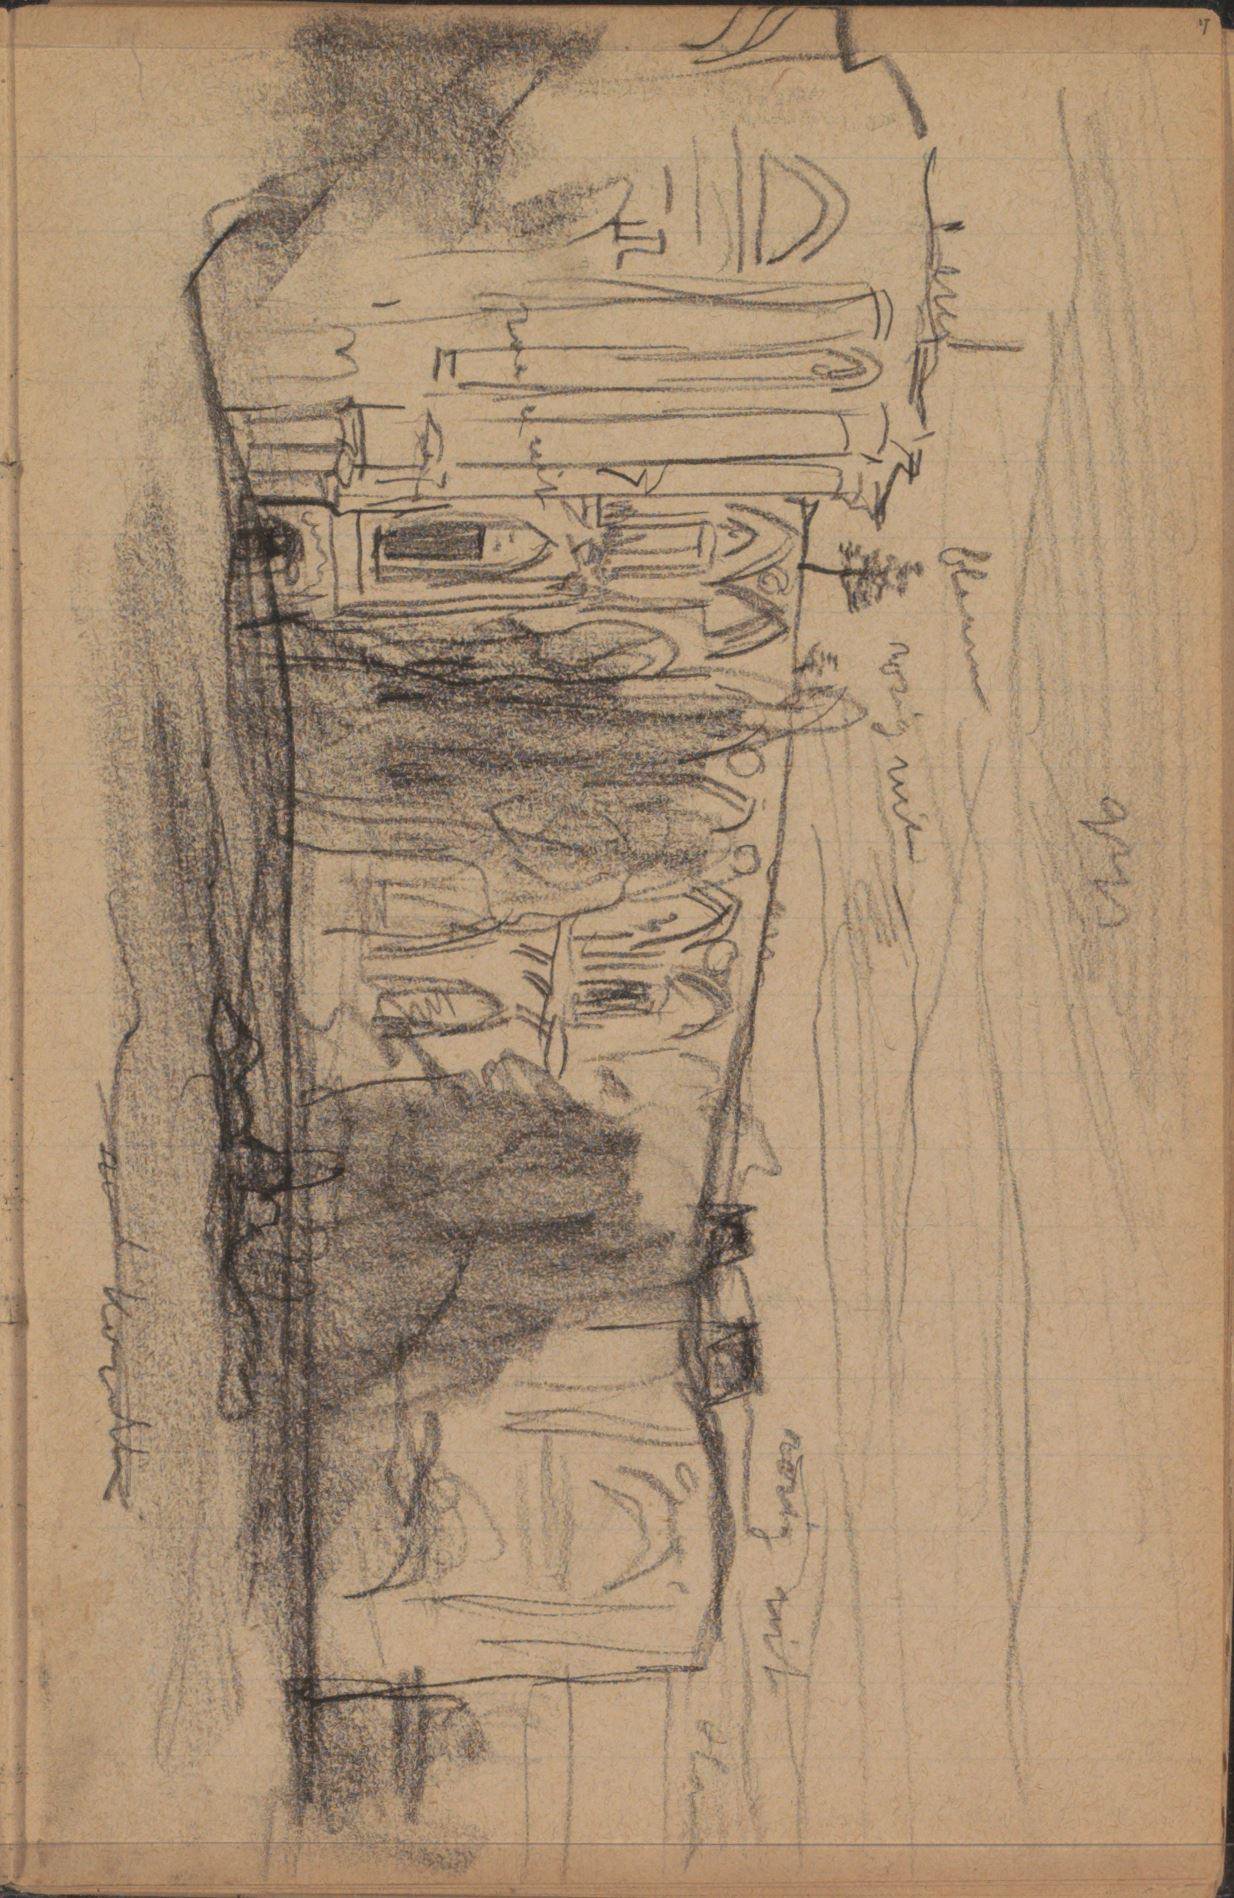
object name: sketchbook leaf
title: Architectuurstudie, mogelijk van een paleis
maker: marius bauer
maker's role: draughtsman, print maker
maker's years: 1867-1932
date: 1896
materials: chalk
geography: russia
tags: architecture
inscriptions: kleurnotitie, handgeschreven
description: Pagina 17 uit een schetsboek met 50 bladen.